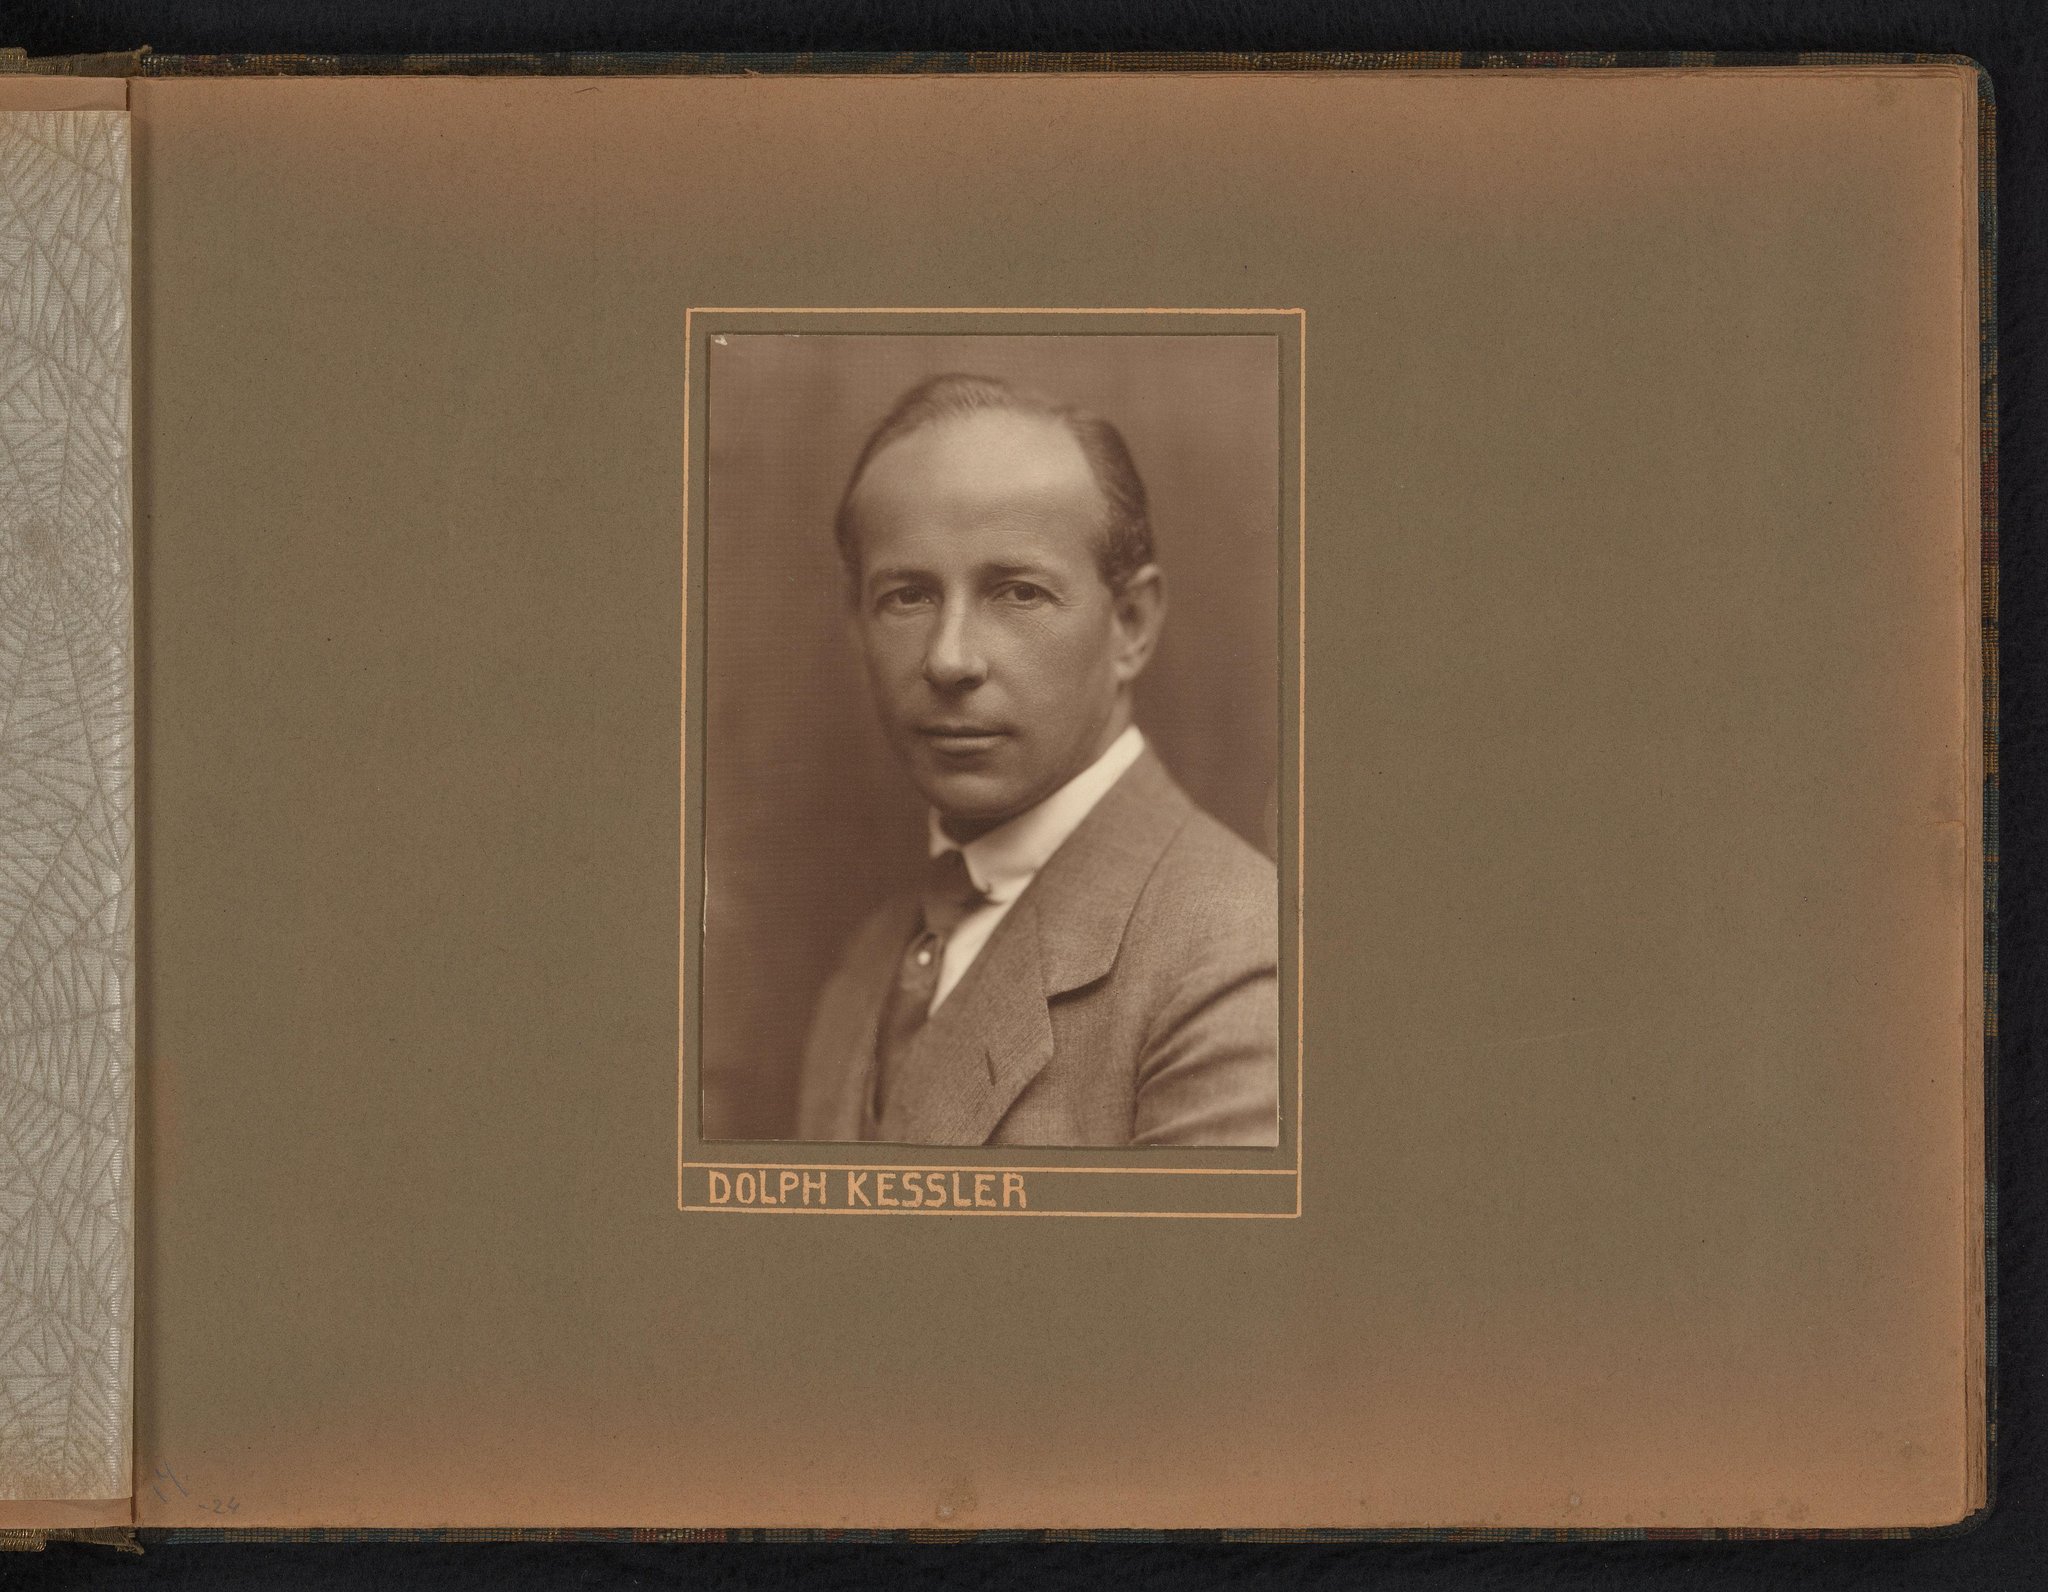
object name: album leaf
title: Dolph Kessler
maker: Anonymous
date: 1920-1930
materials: paper, cardboard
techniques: gelatin silver print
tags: batavia, geldolph adriaan kessler (dolph), historical persons